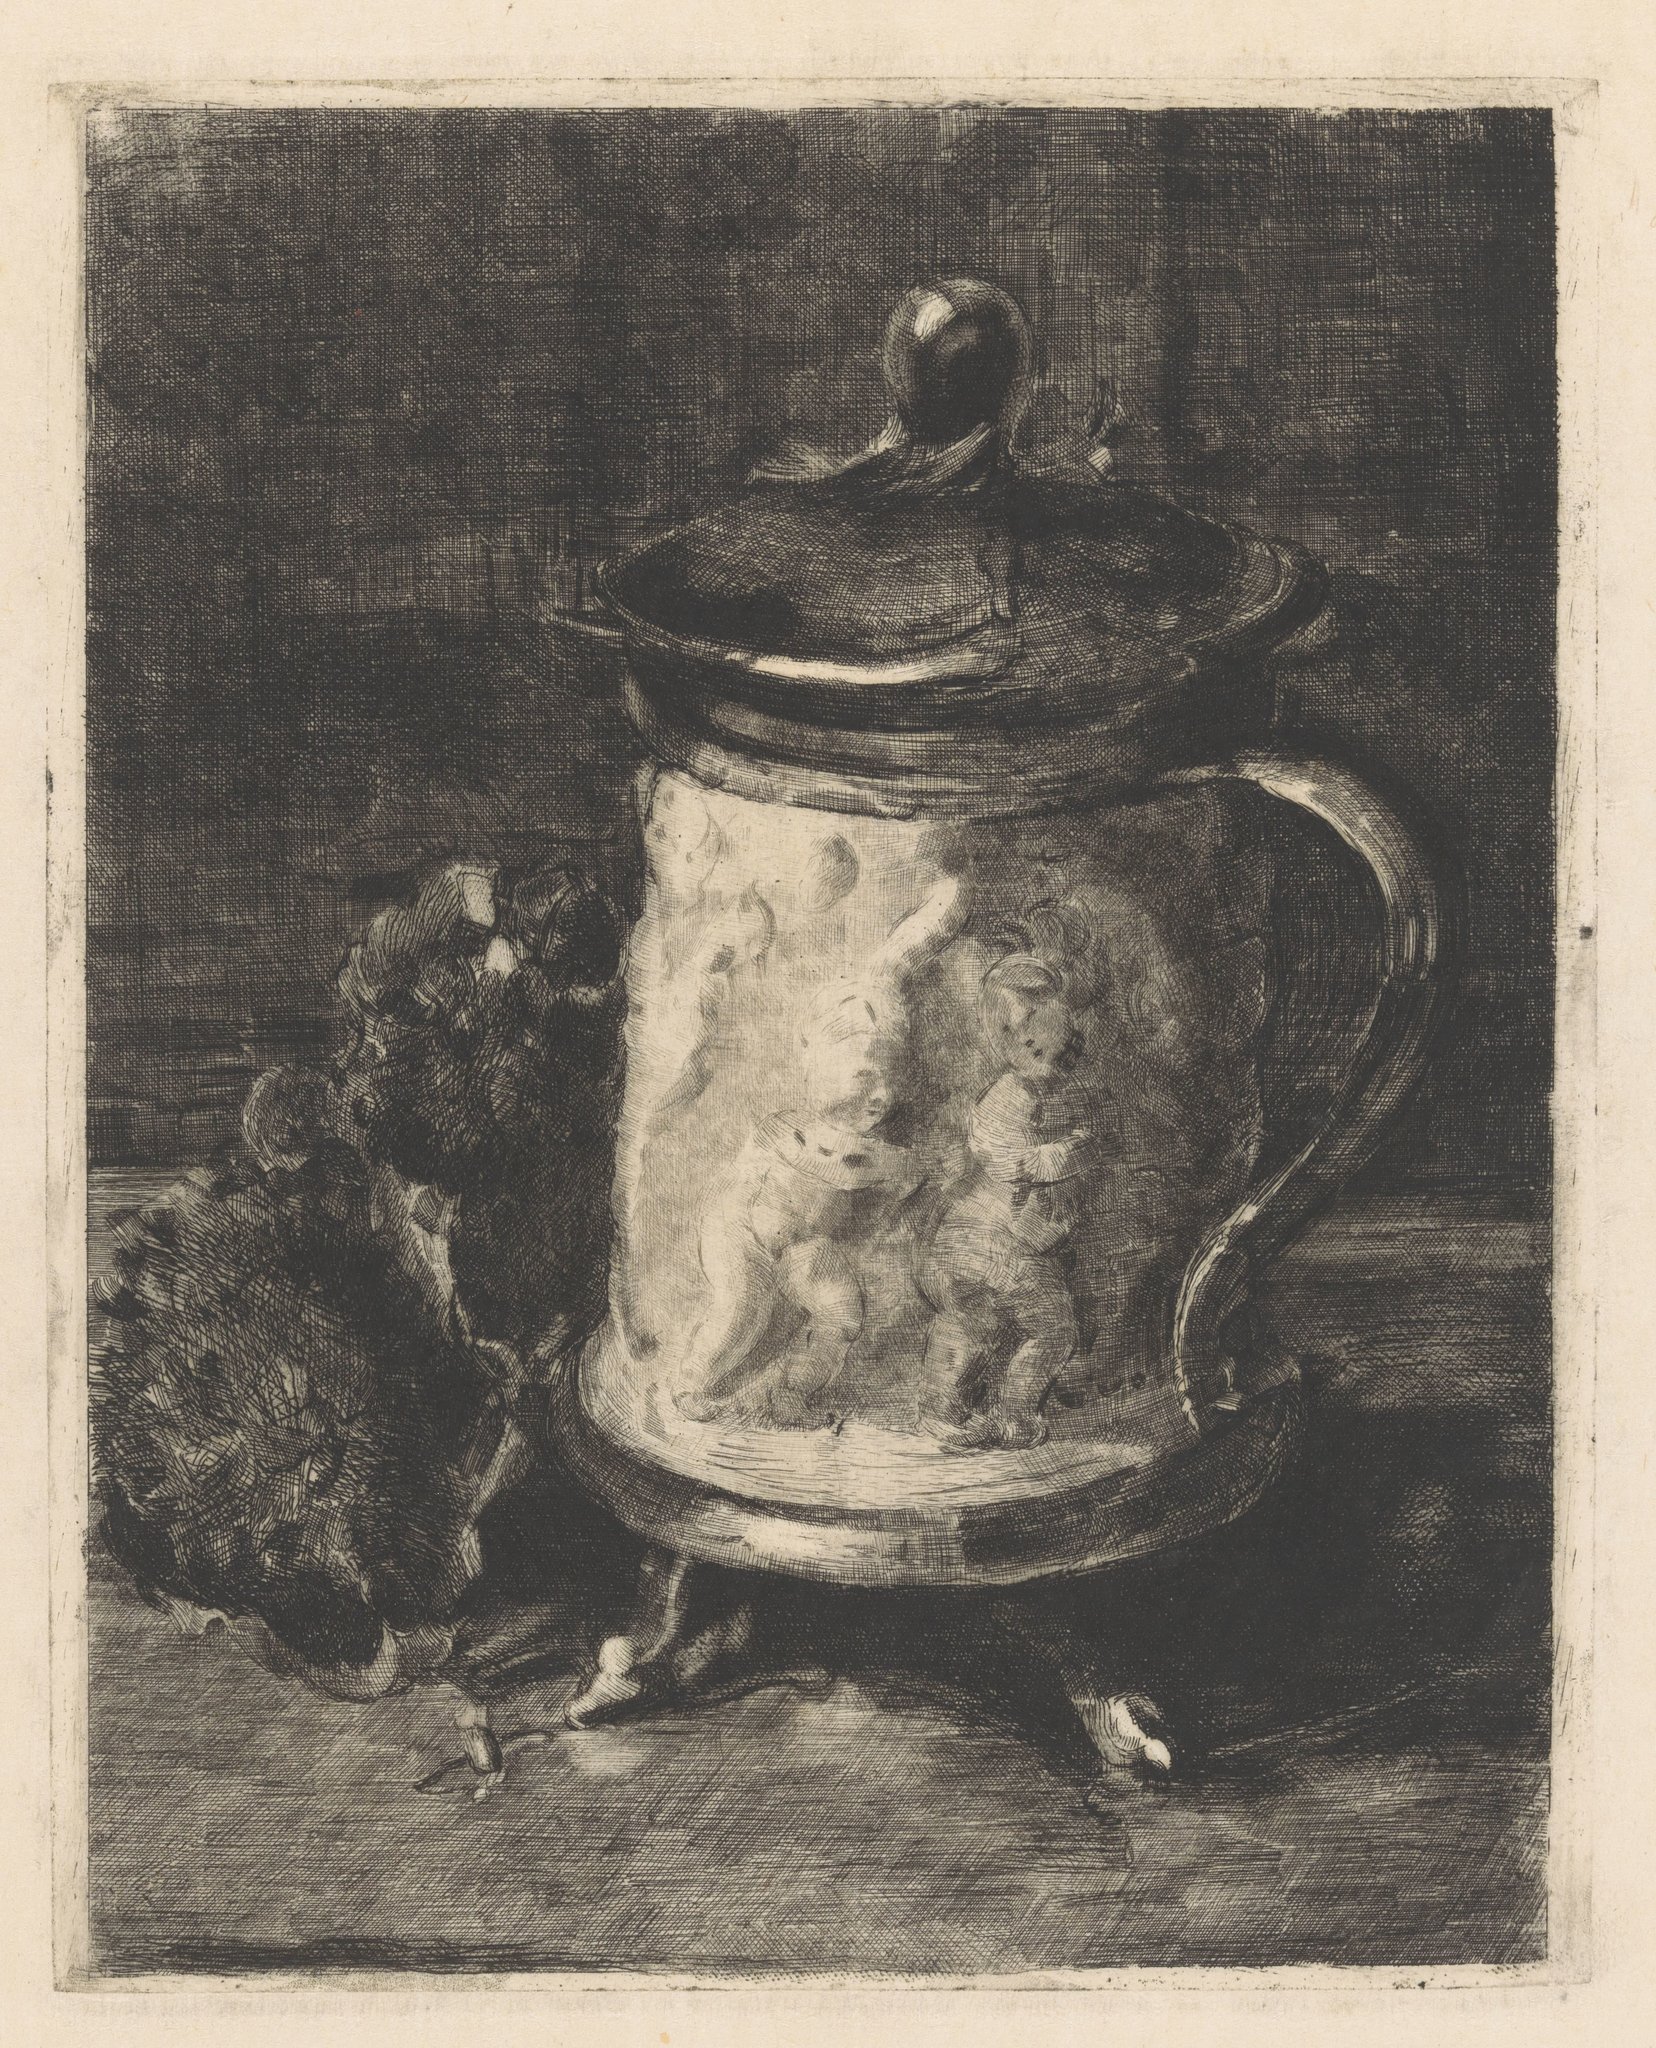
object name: print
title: Stilleven met bierpul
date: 1877-1950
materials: paper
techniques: etching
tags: flowers, mug, beaker, goblet, still life of miscellaneous objects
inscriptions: collector's mark: Lugt 2228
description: Op de pul een reliëf van gesneden ivoor. Links twee bloemen.